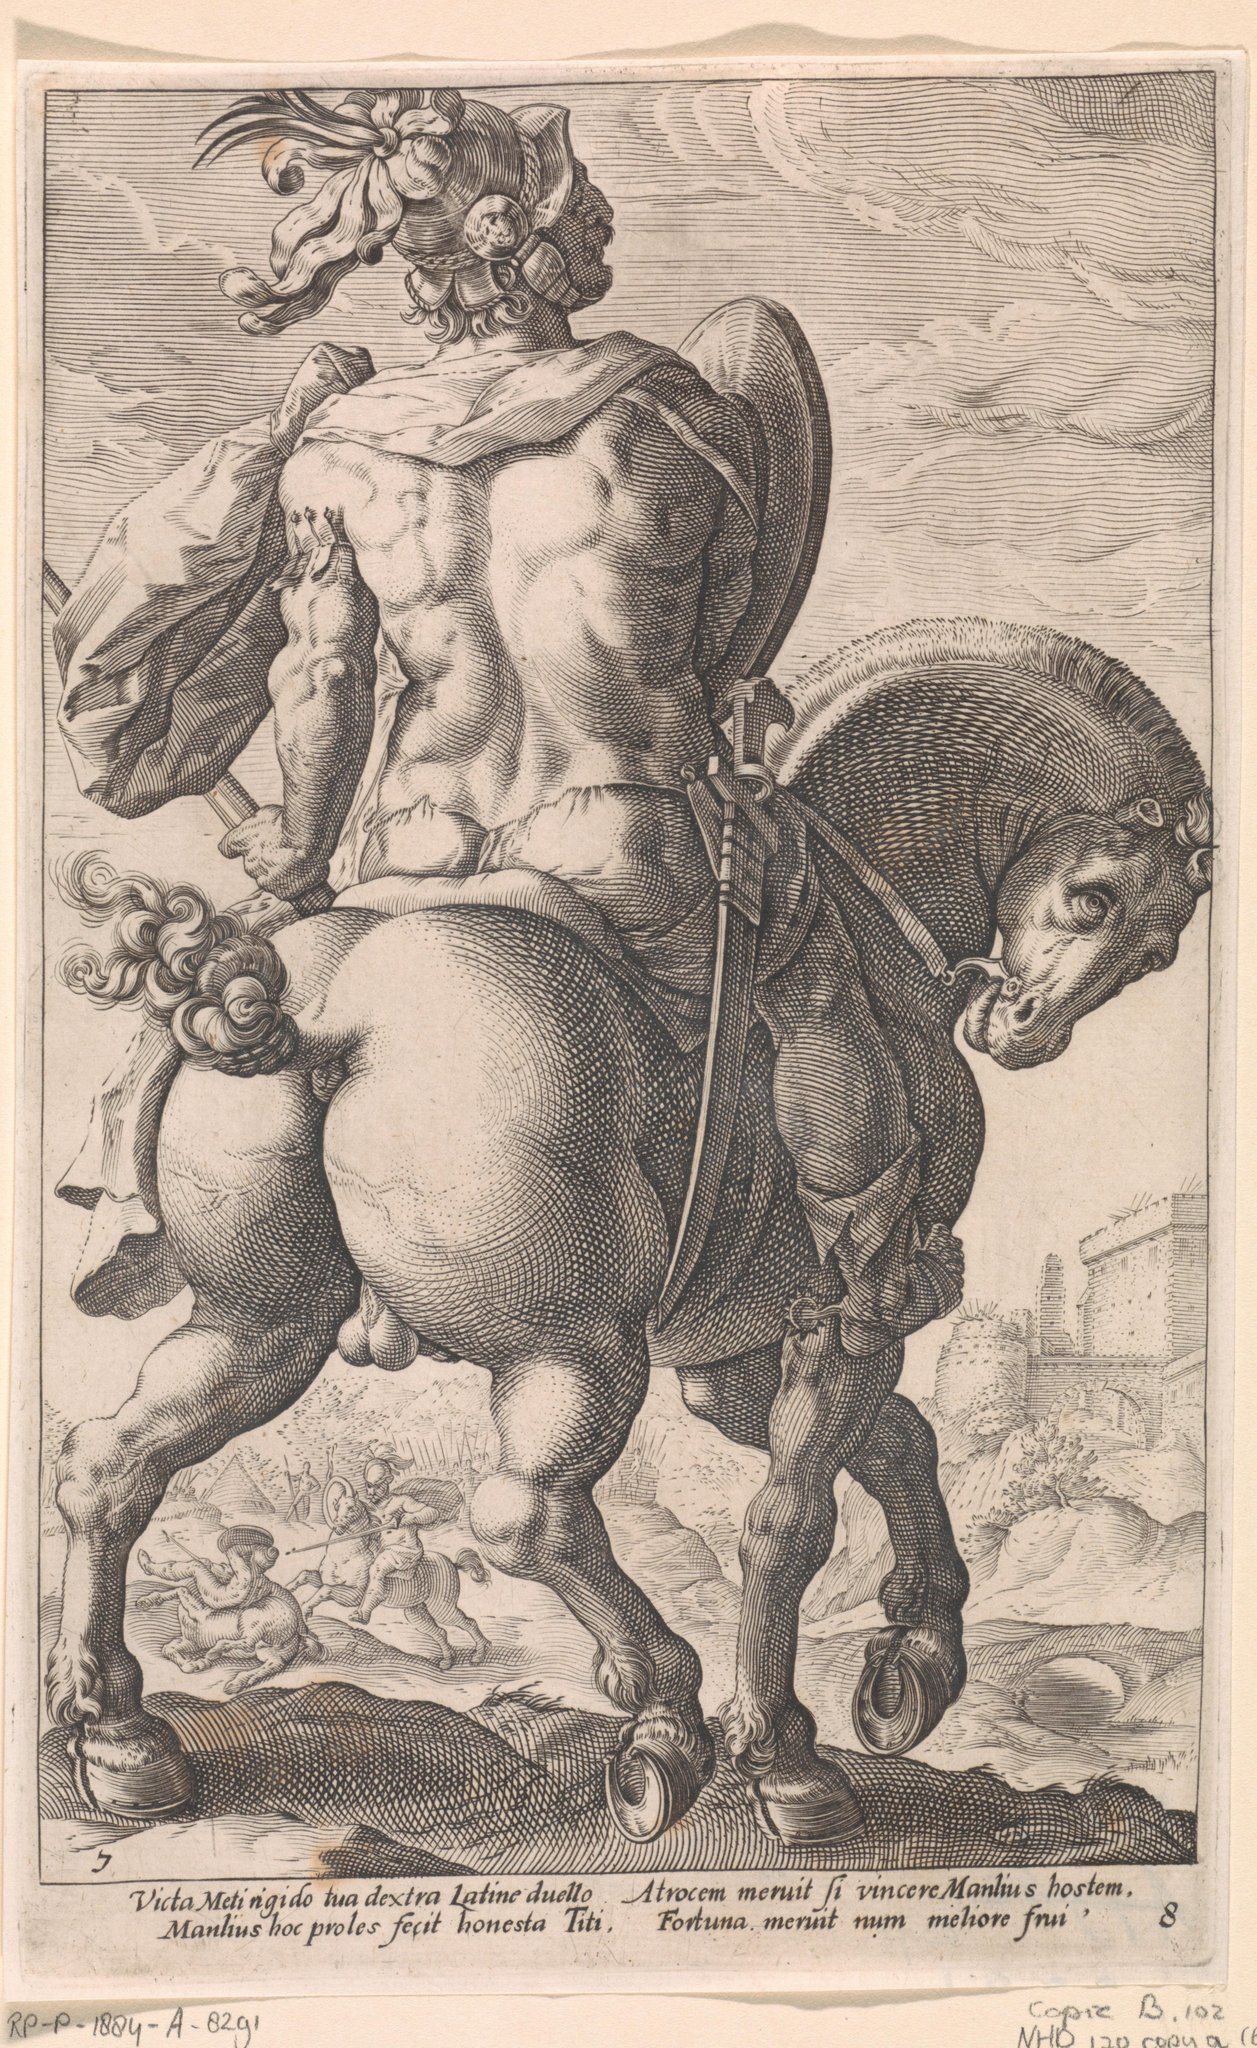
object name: print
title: Titus Manlius te paard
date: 1645-1706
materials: paper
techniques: engraving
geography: amsterdam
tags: (story of) titus manlius torquatus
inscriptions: collector's mark: Lugt 2228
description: De held Titus Manlius te paard, op de rug gezien. Op de achtergrond is te zien hoe hij een tegenstander te paard verslaat. Onder de voorstelling twee maal twee versregels in Latijn.